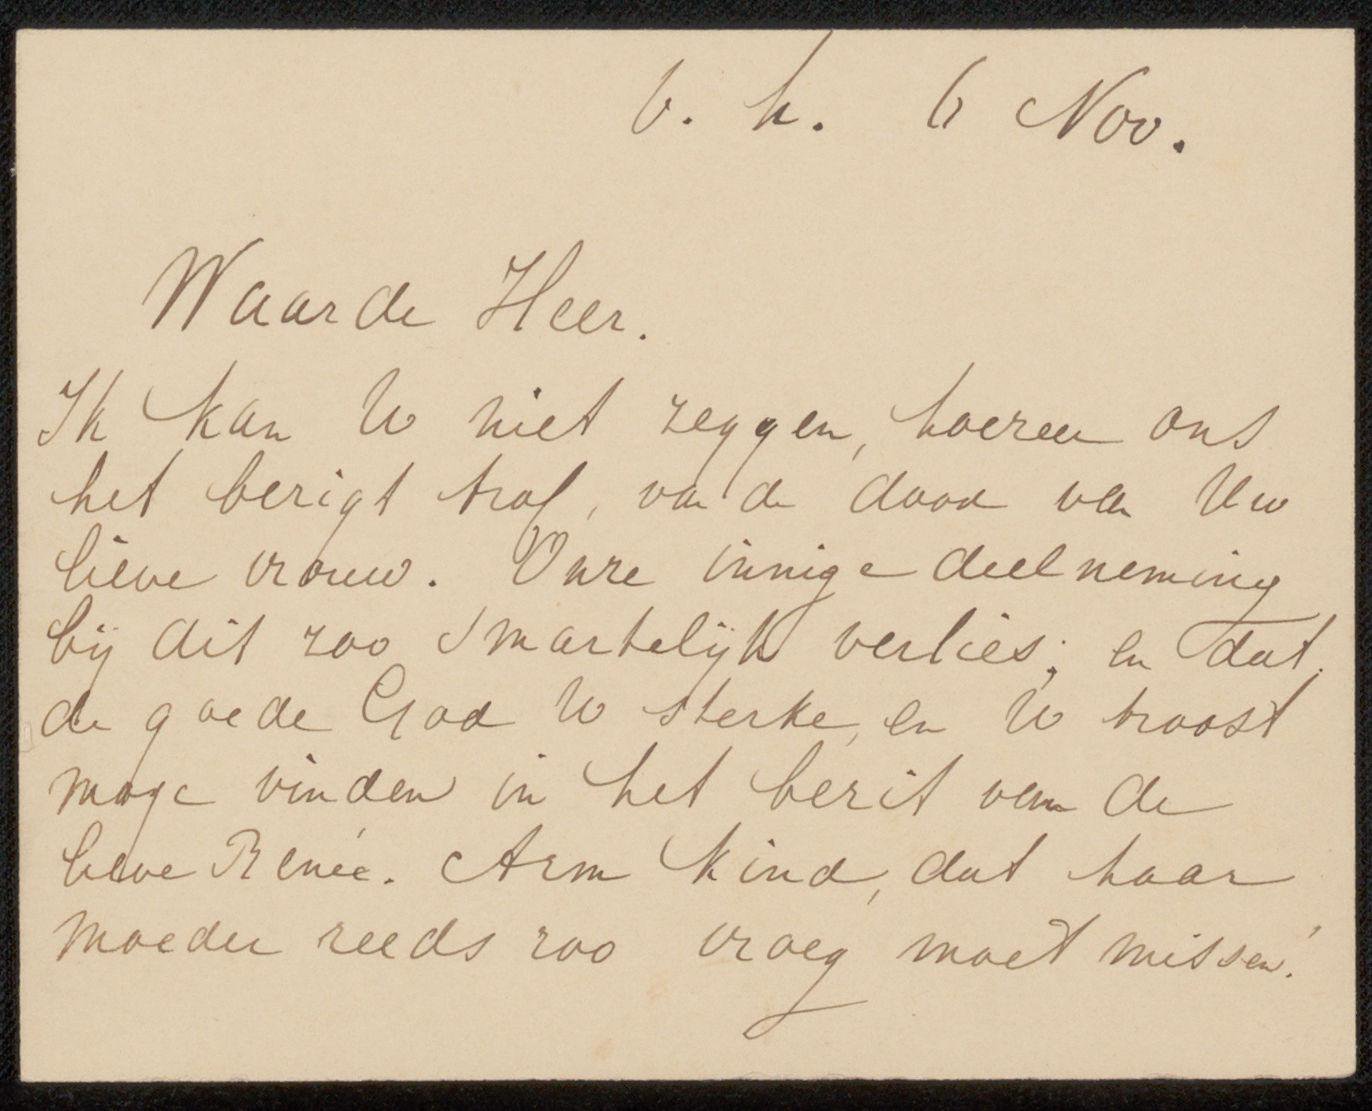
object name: letter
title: Brief aan Philip Zilcken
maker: m. wirtz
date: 1895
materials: cardboard, ink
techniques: pen, writing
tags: brussels, helène lambertine hauzeur, the hague, painter, draughtsman, philip zilcken, family life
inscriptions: collector's mark: ‘RPK’